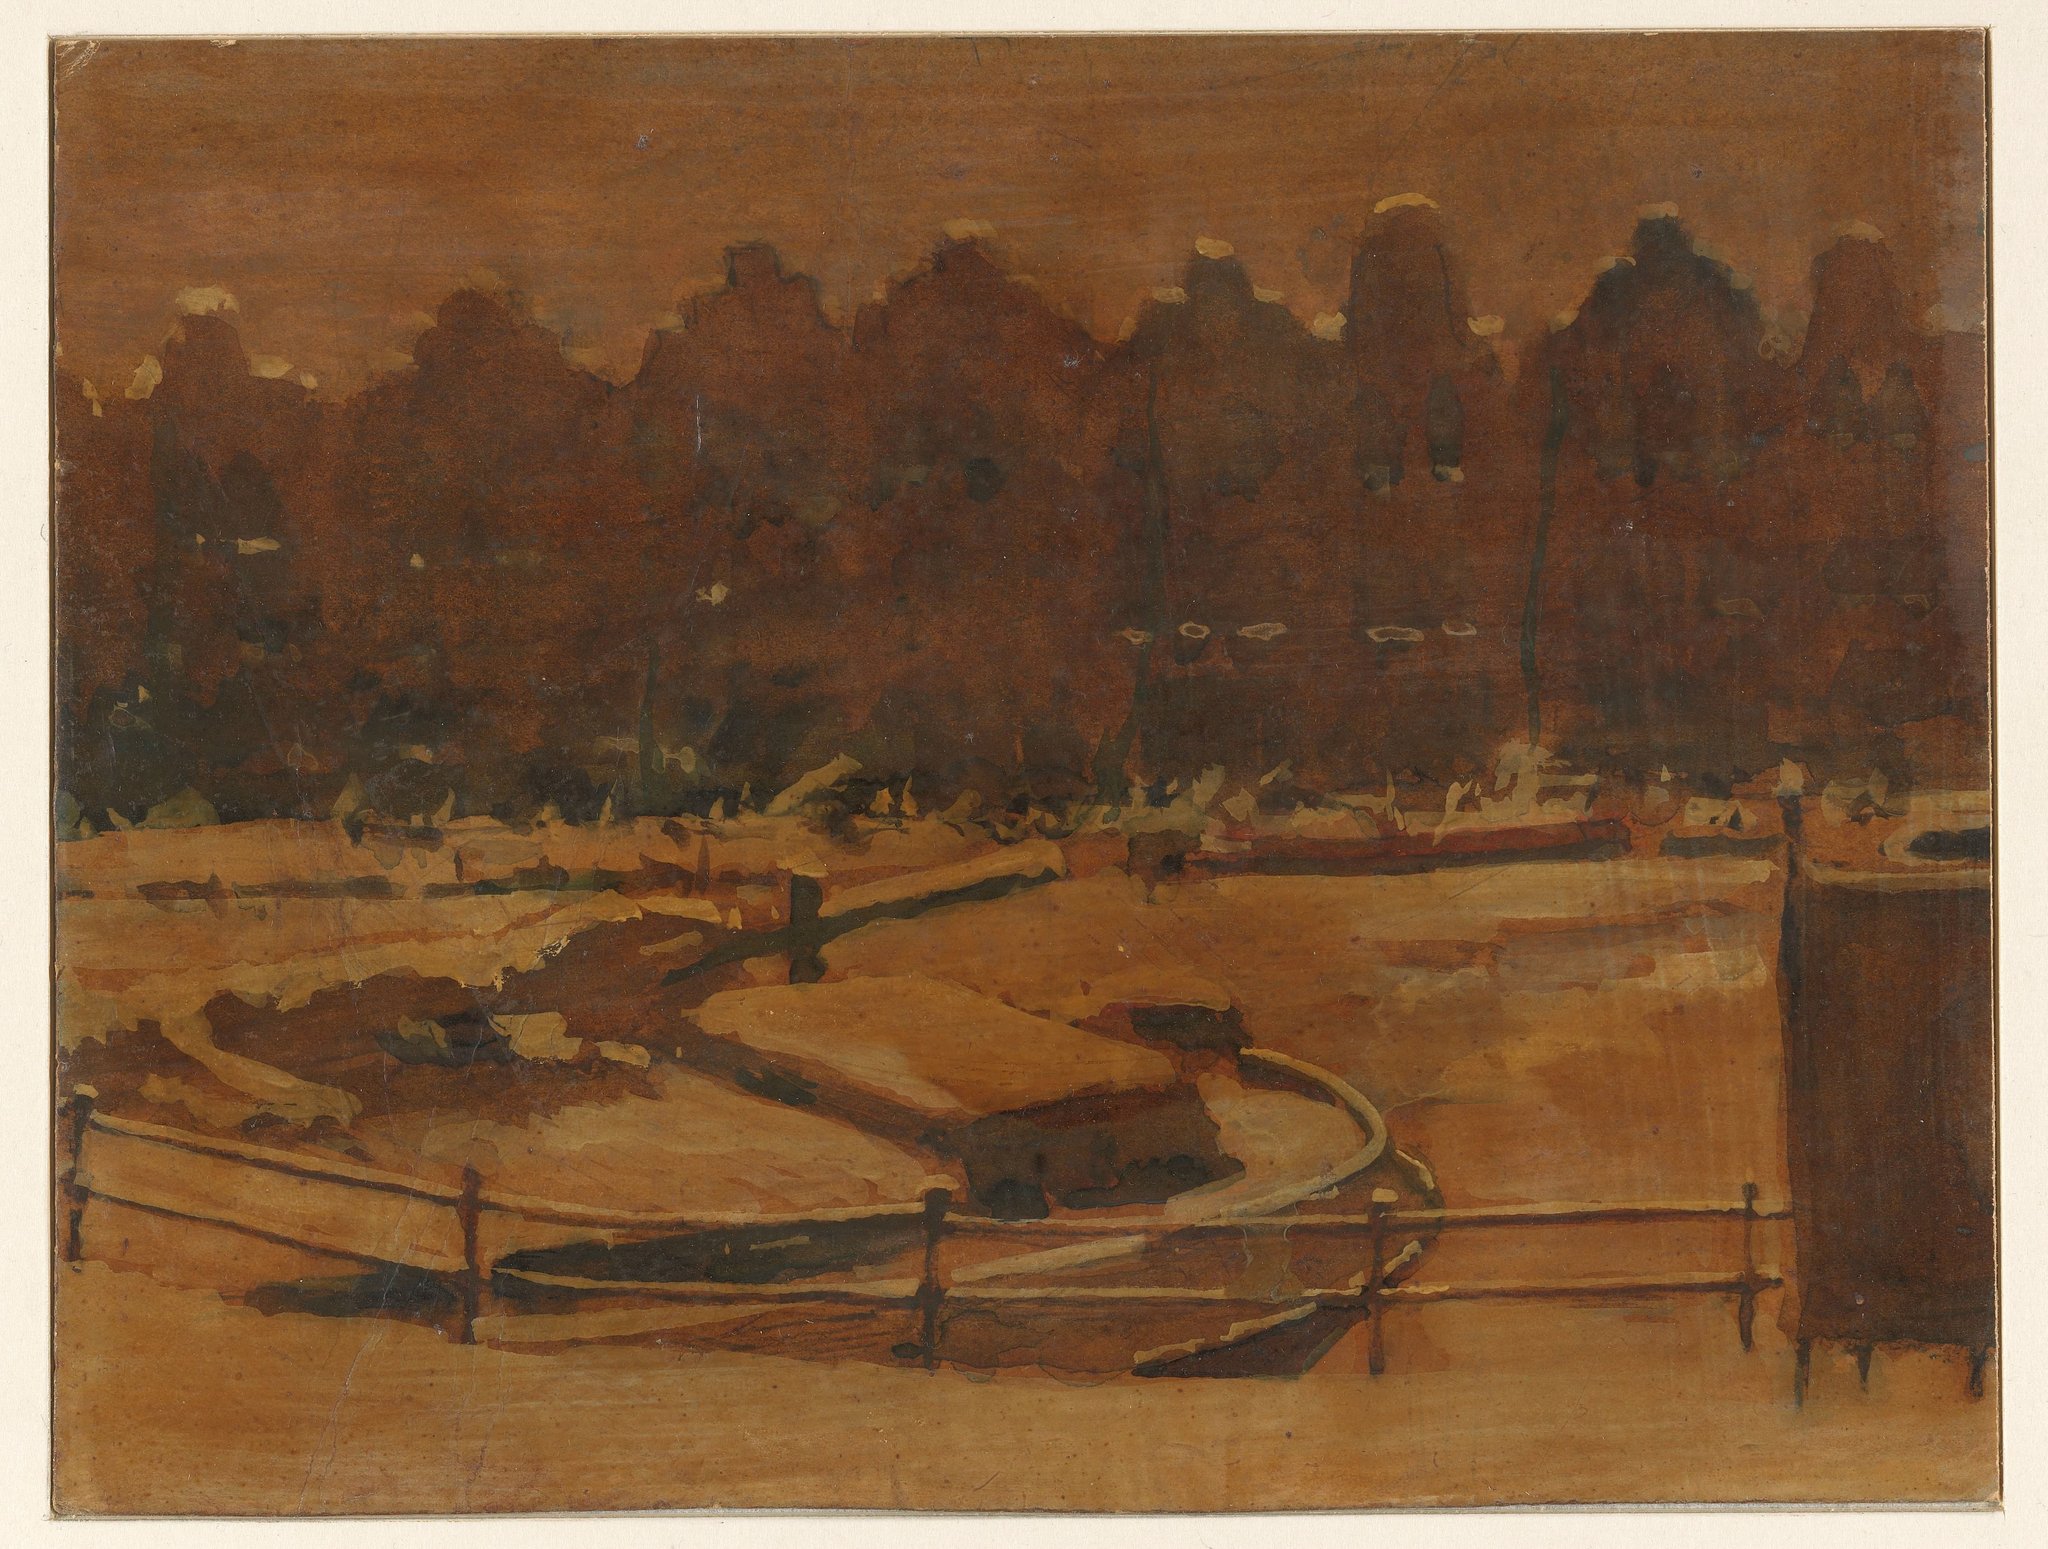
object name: drawing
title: Pakhuizen aan een Amsterdamse kade in de sneeuw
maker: willem witsen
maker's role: draughtsman, painter, print maker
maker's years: 1860-1923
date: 1870-1923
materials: cardboard, chalk, oil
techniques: brush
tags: canals, waters (in city), snow, amsterdam